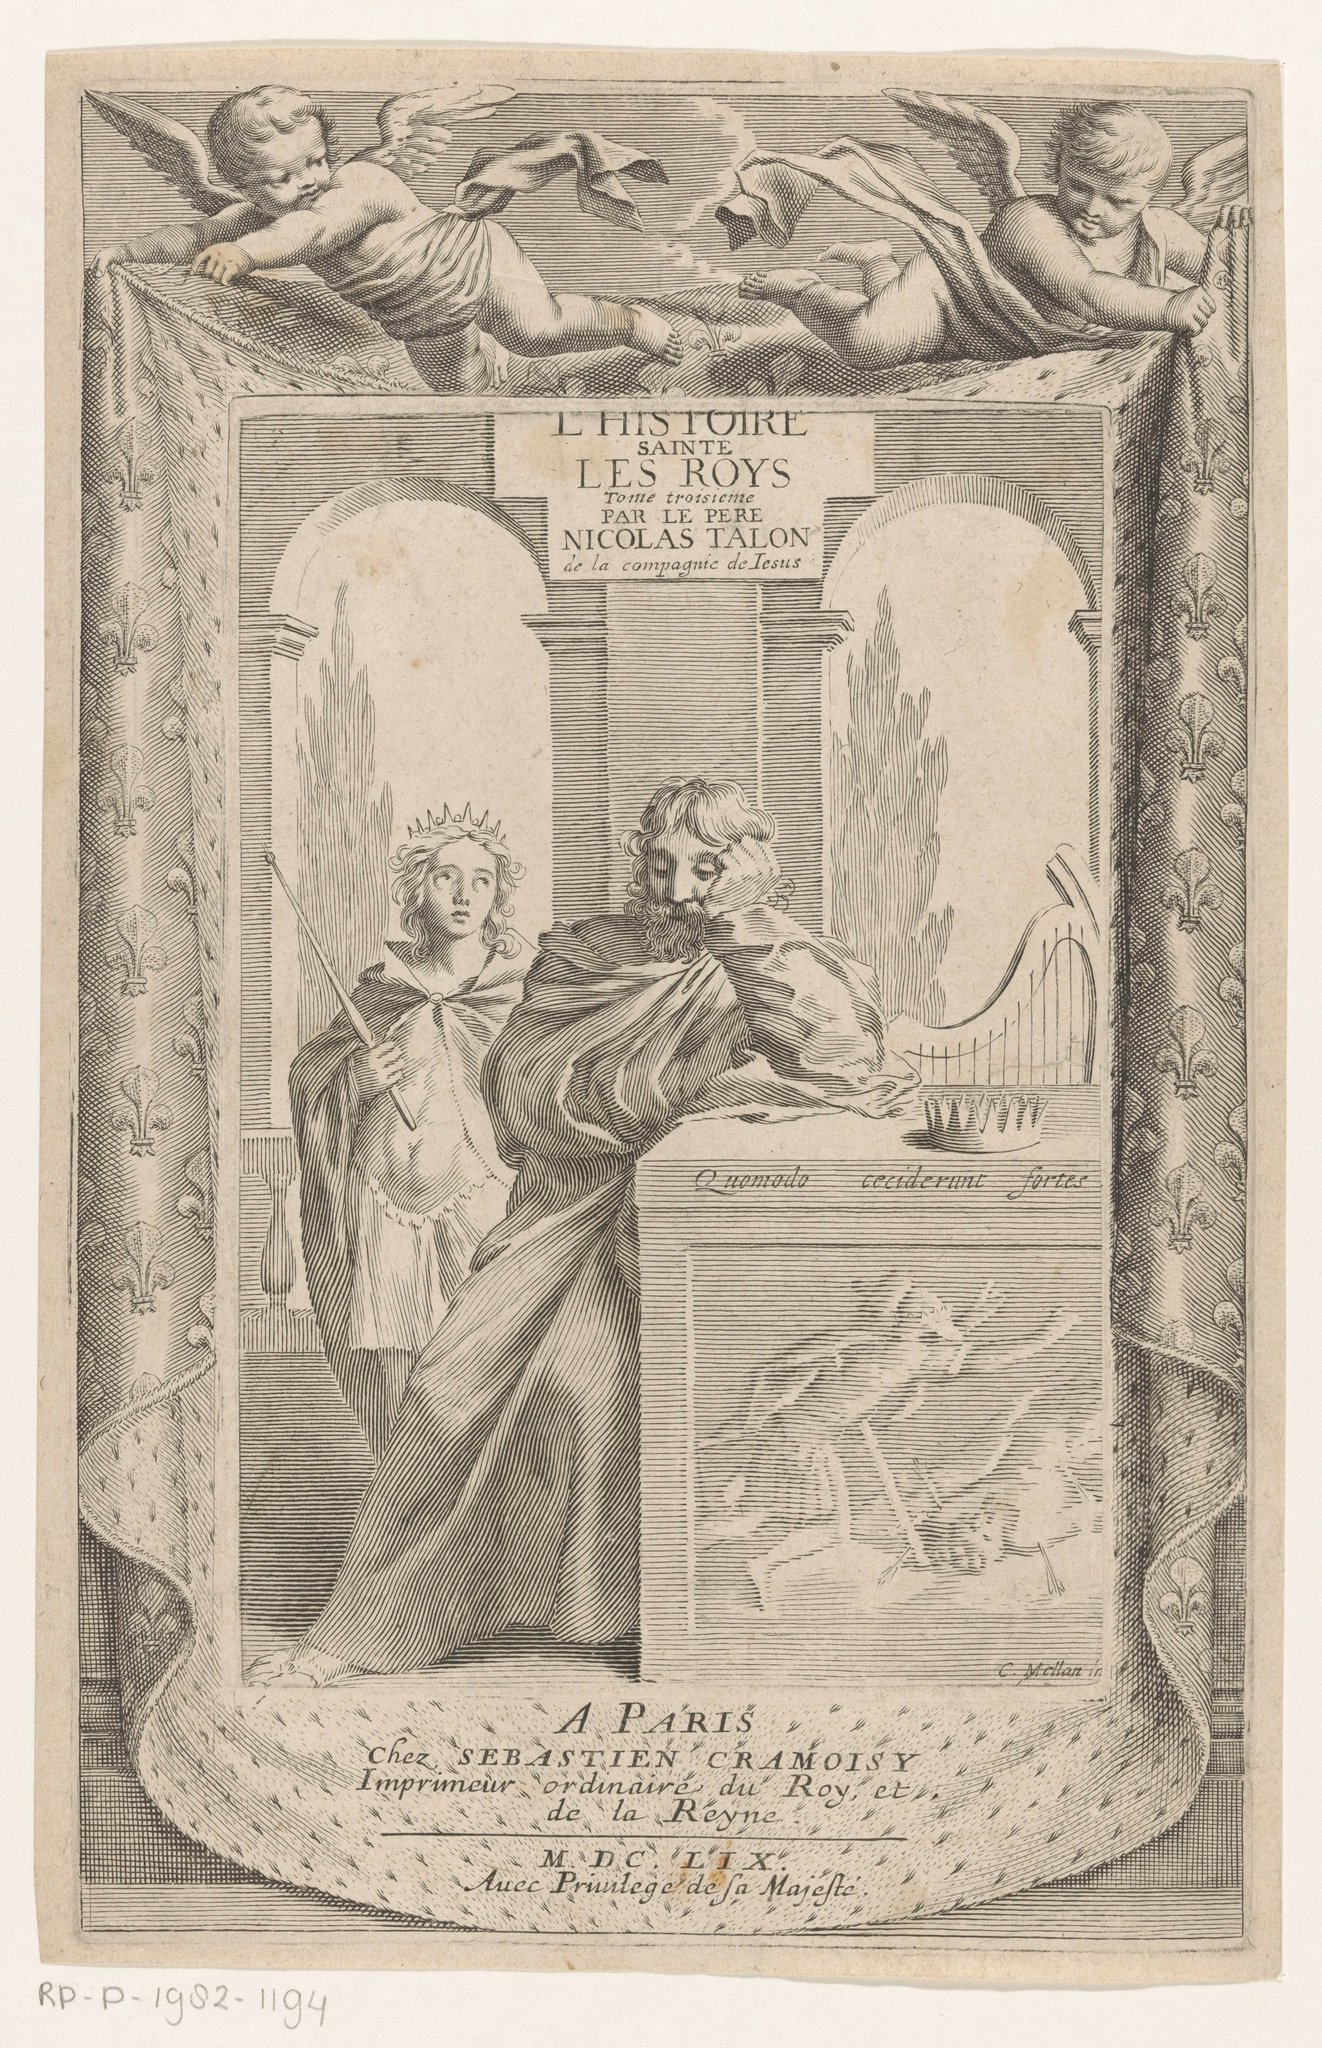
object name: titelblad, titelpagina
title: Titelpagina voor: Nicolas Talon, L'Histoire sainte les rois, Tome troisième, 1659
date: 1659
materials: paper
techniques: engraving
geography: paris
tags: story of david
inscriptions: collector's mark: Lugt 2760, collector's mark: Lugt 2228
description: Koning David leunend tegen een voetstuk met een bas-reliëf en Davids kroon. Achter het voetstuk staat zijn harp. Links staat een koningin met kroon en scepter, vermoedelijk één van de vrouwen van David.